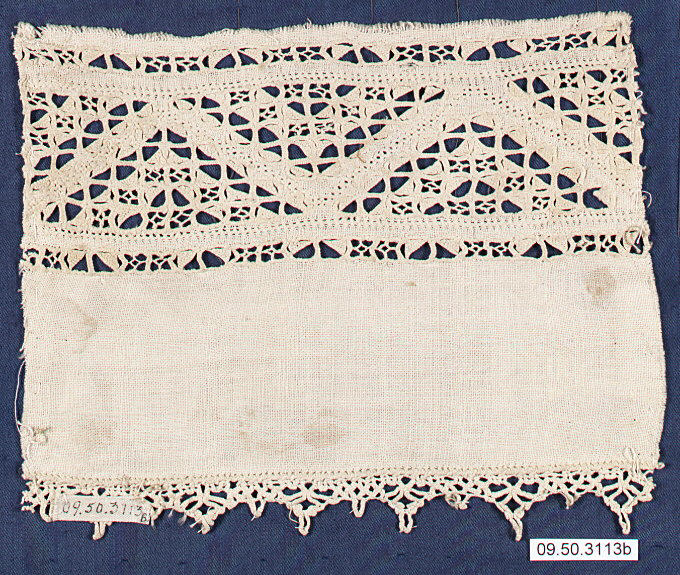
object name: fragment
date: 1501-1600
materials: linen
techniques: embroidery